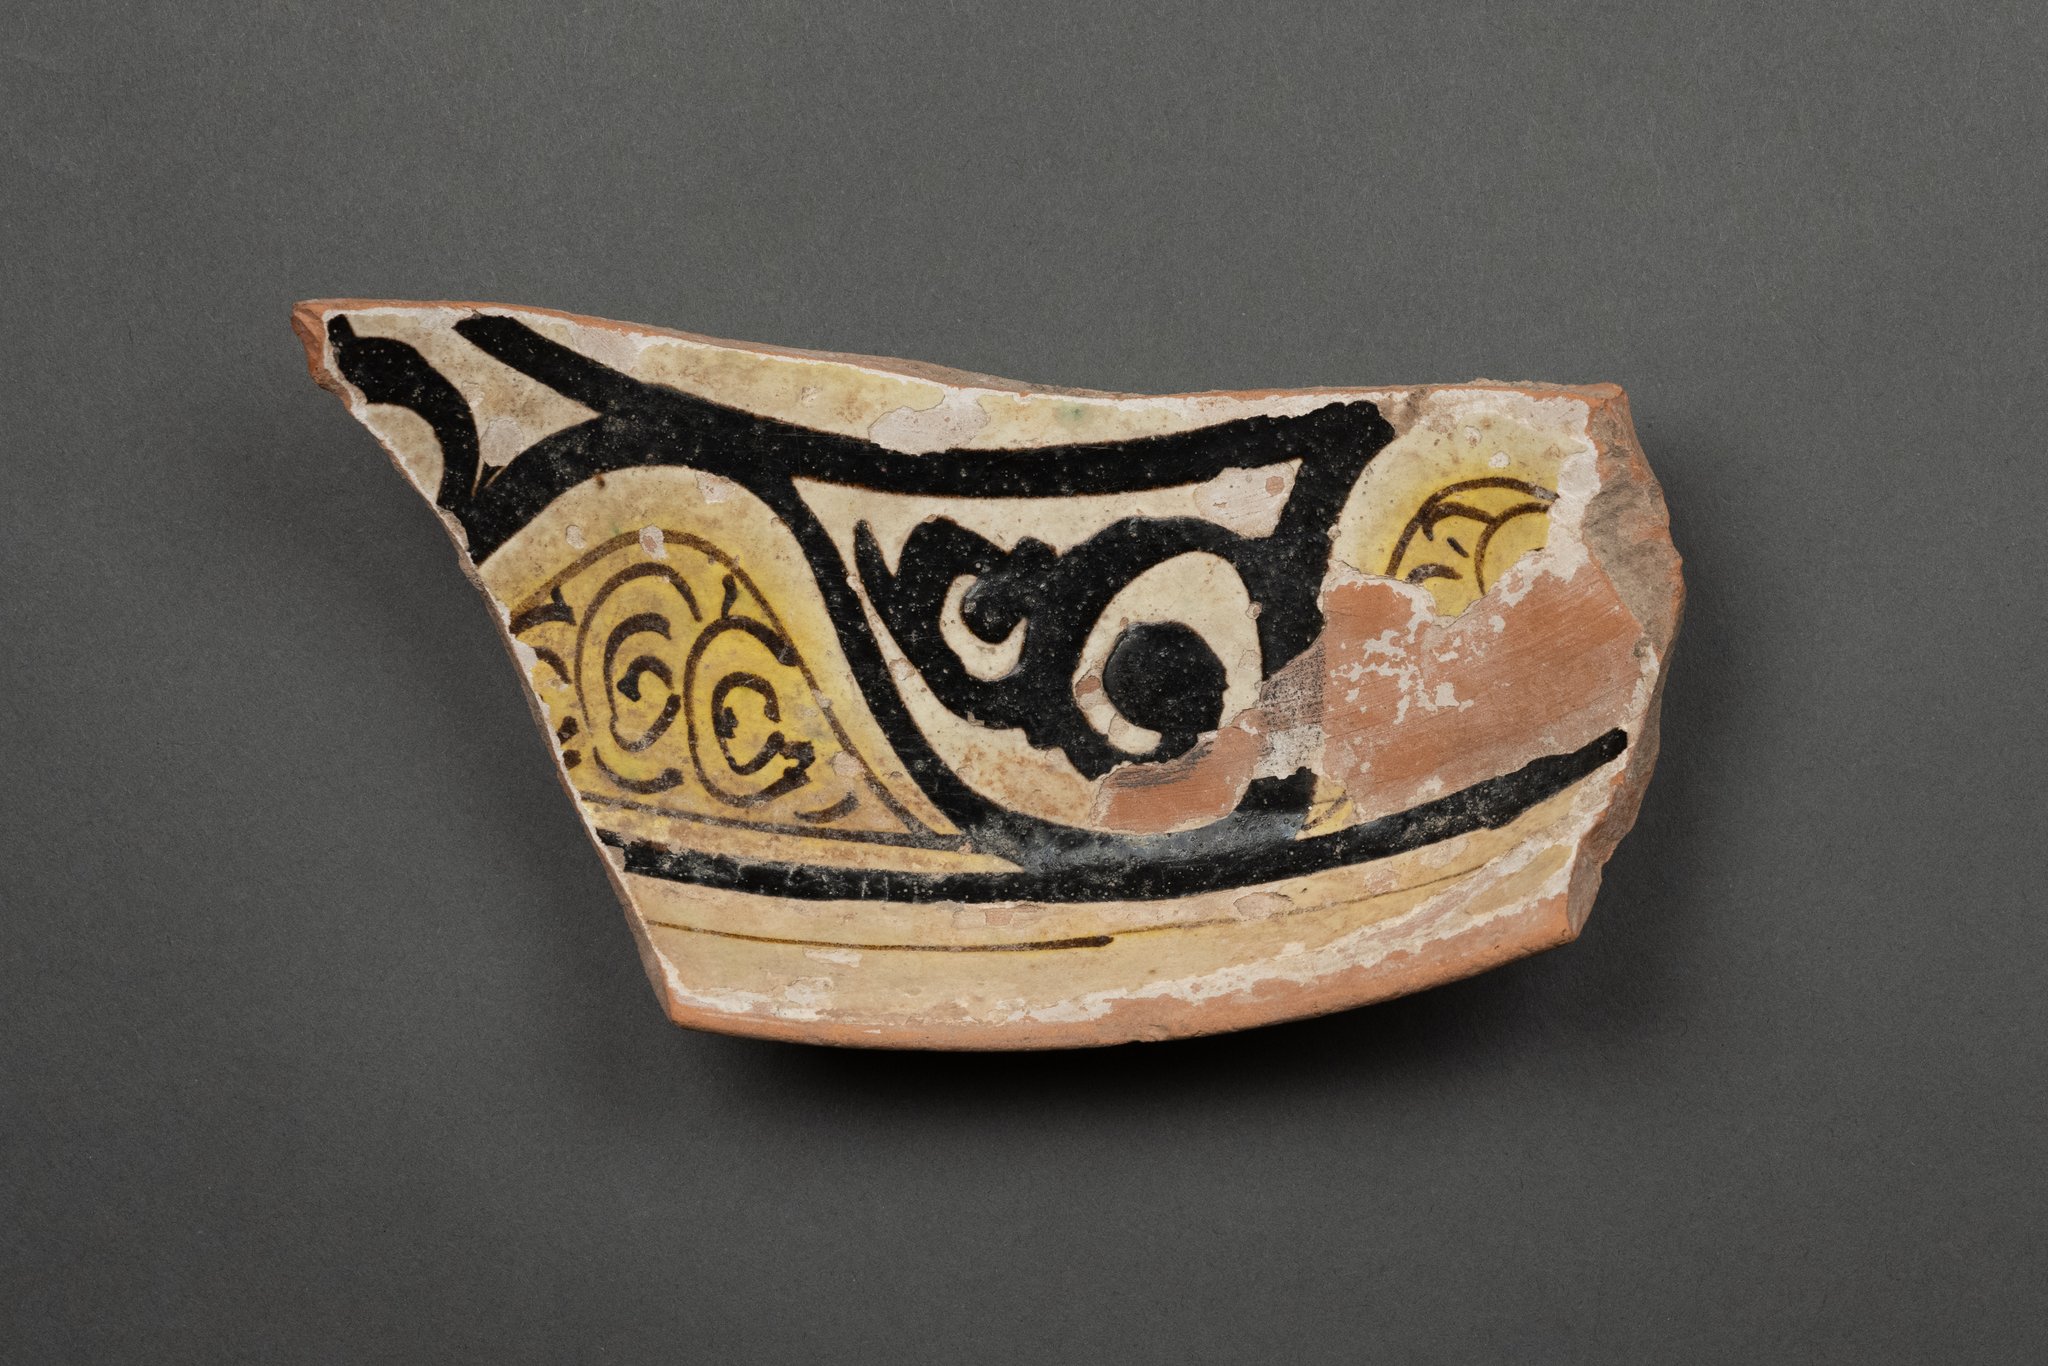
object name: fragment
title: Fragment of a Bowl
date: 801-1000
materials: earthenware, glaze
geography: iran